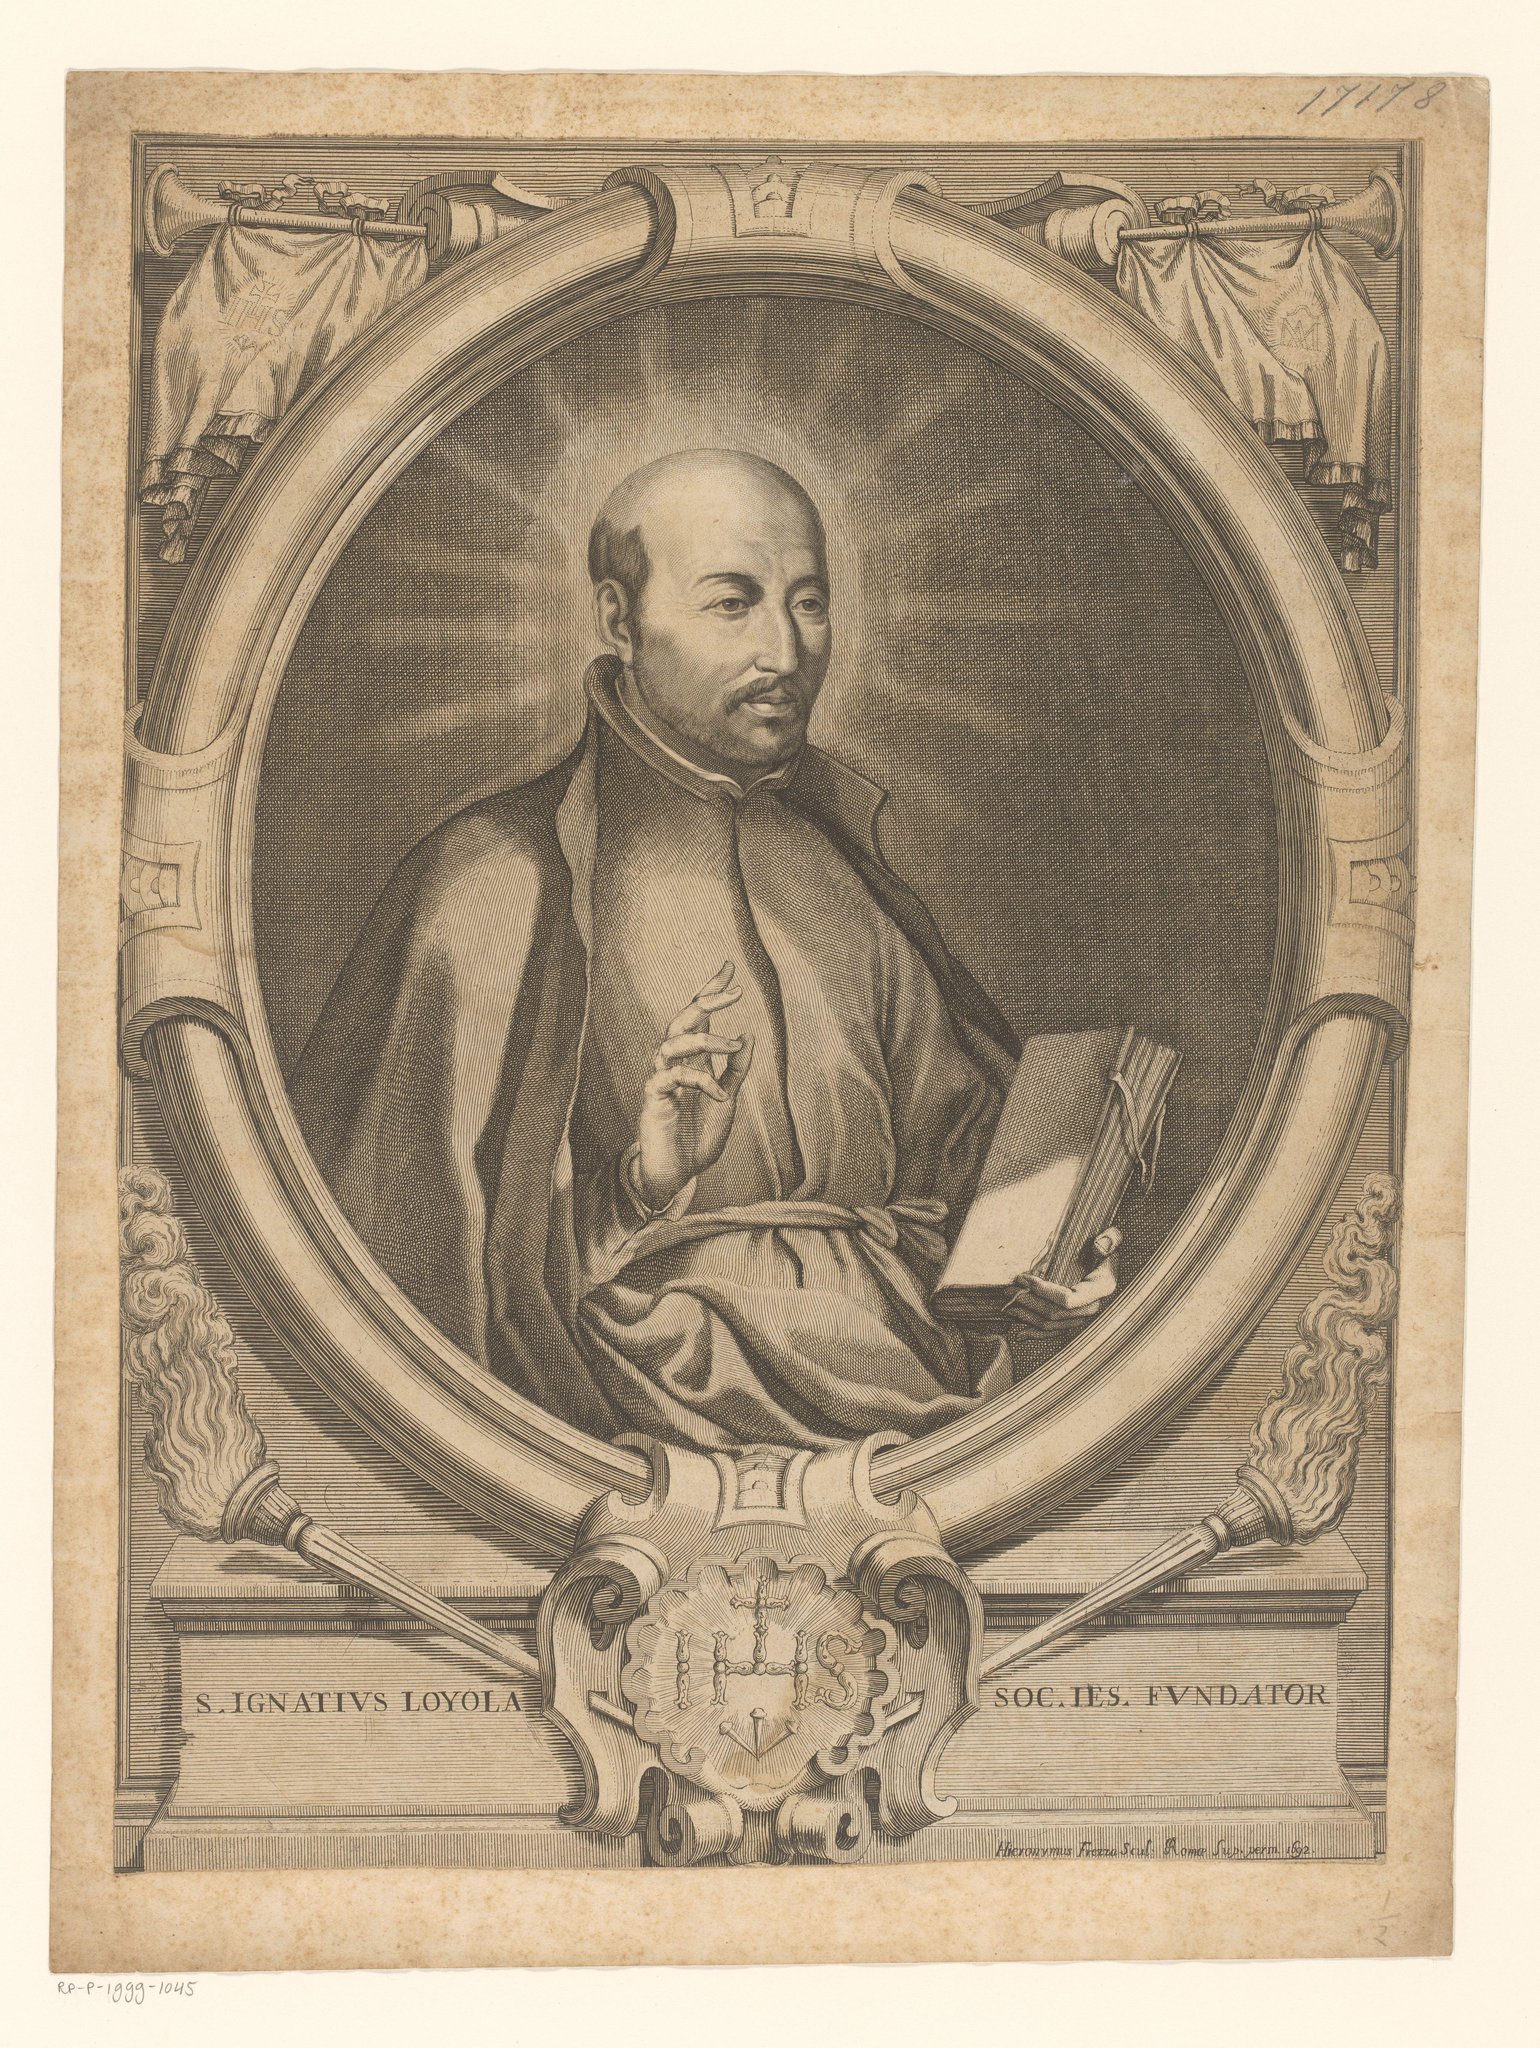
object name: print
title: De heilige Ignatius van Loyola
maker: giovanni girolamo frezza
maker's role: print maker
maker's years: 1659-1748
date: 1692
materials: paper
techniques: engraving, etching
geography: rome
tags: historical persons, the founder of the jesuit order, ignatius of loyola; possible attributes: book (with 'ad majorem dei gloriam'), demon, dragon under feet, flames, flaming heart, globe, ihs monogram, skull (with crown), tears in eyes, torch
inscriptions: collector's mark: Lugt 2228, collector's mark: Lugt 2760